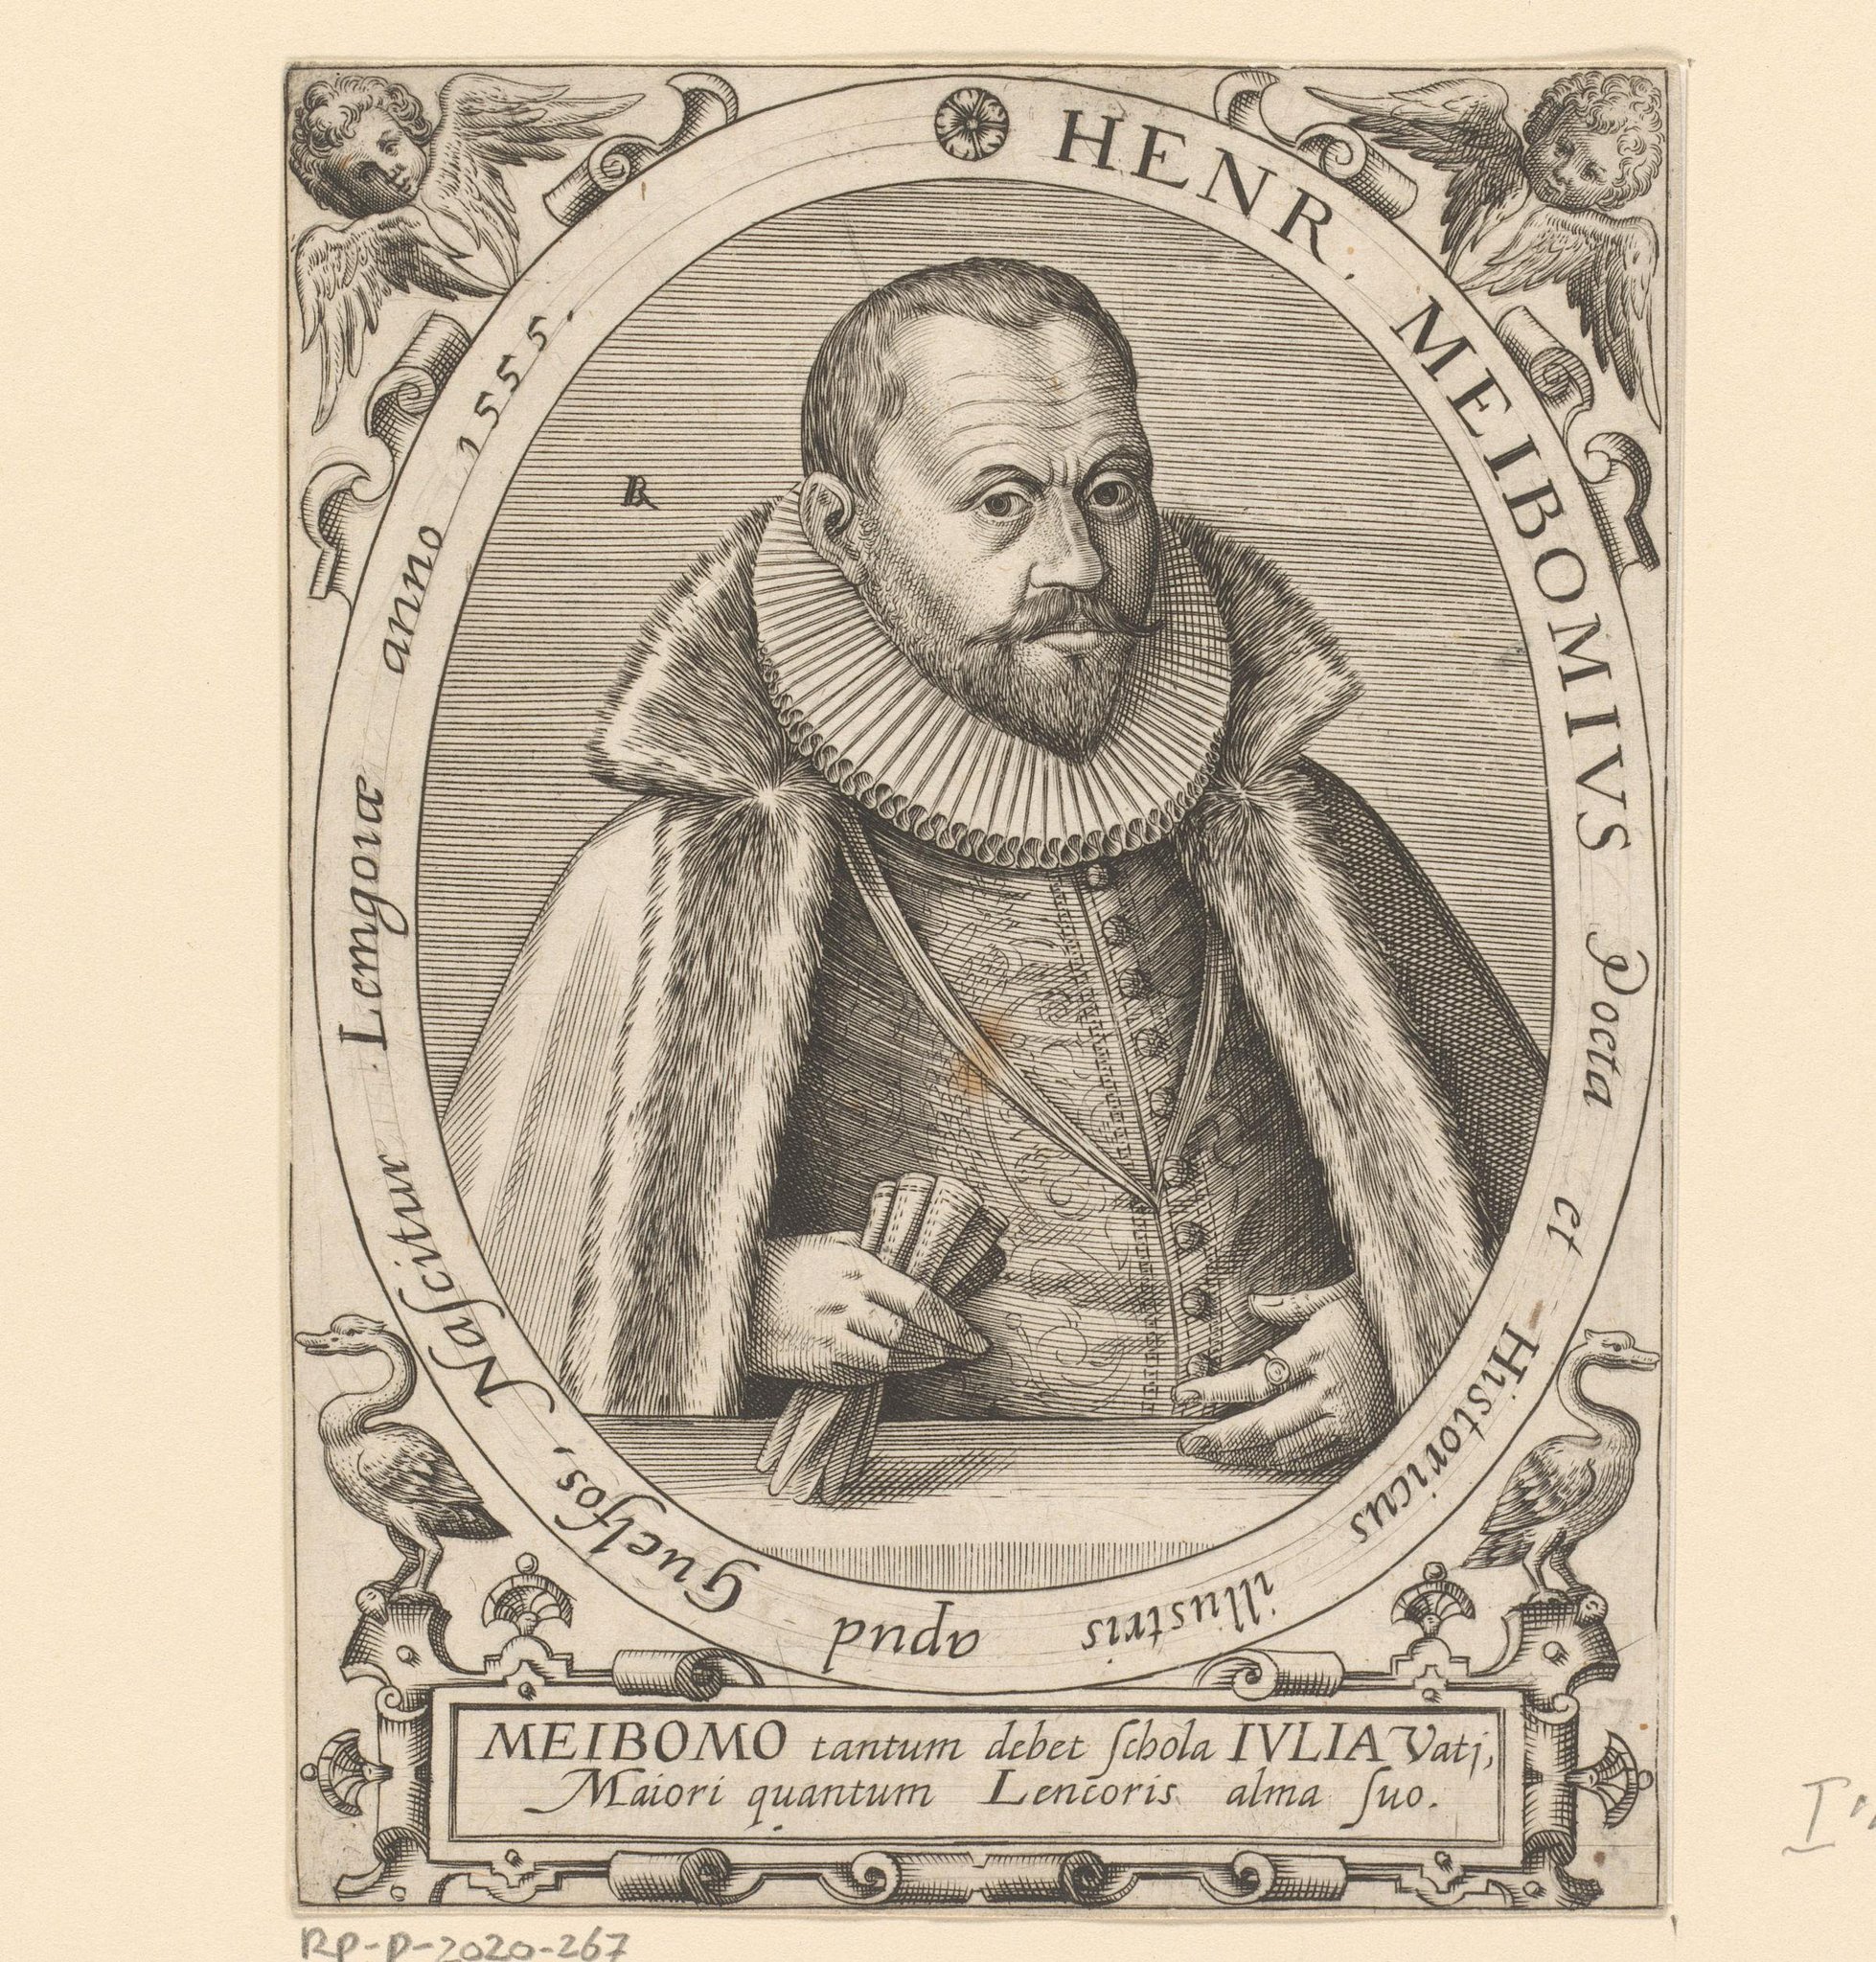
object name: print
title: Henr. Meibomius poeta et historicus illustris apud Guelfos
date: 1598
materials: paper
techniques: engraving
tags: historical persons, portrait of a writer, writer, poet, author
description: Prent gebruikt in: Boissard, Jean Jacques. Icones quinquaginta virorum illustrium doctrina & eruditione praestantium ad vivum effictae. 4 dln. Frankfurt am Main: s.n., 1597-1599. Mogelijk ook gebruikt in latere edities. Latere staat van prent verschenen in: Boissard, Jean Jacques. Bibliotheca chalcographica. 8 dln. Frankfurt am Main: Johannes Ammon, 1650-1652. Ook gebruikt in latere edities.